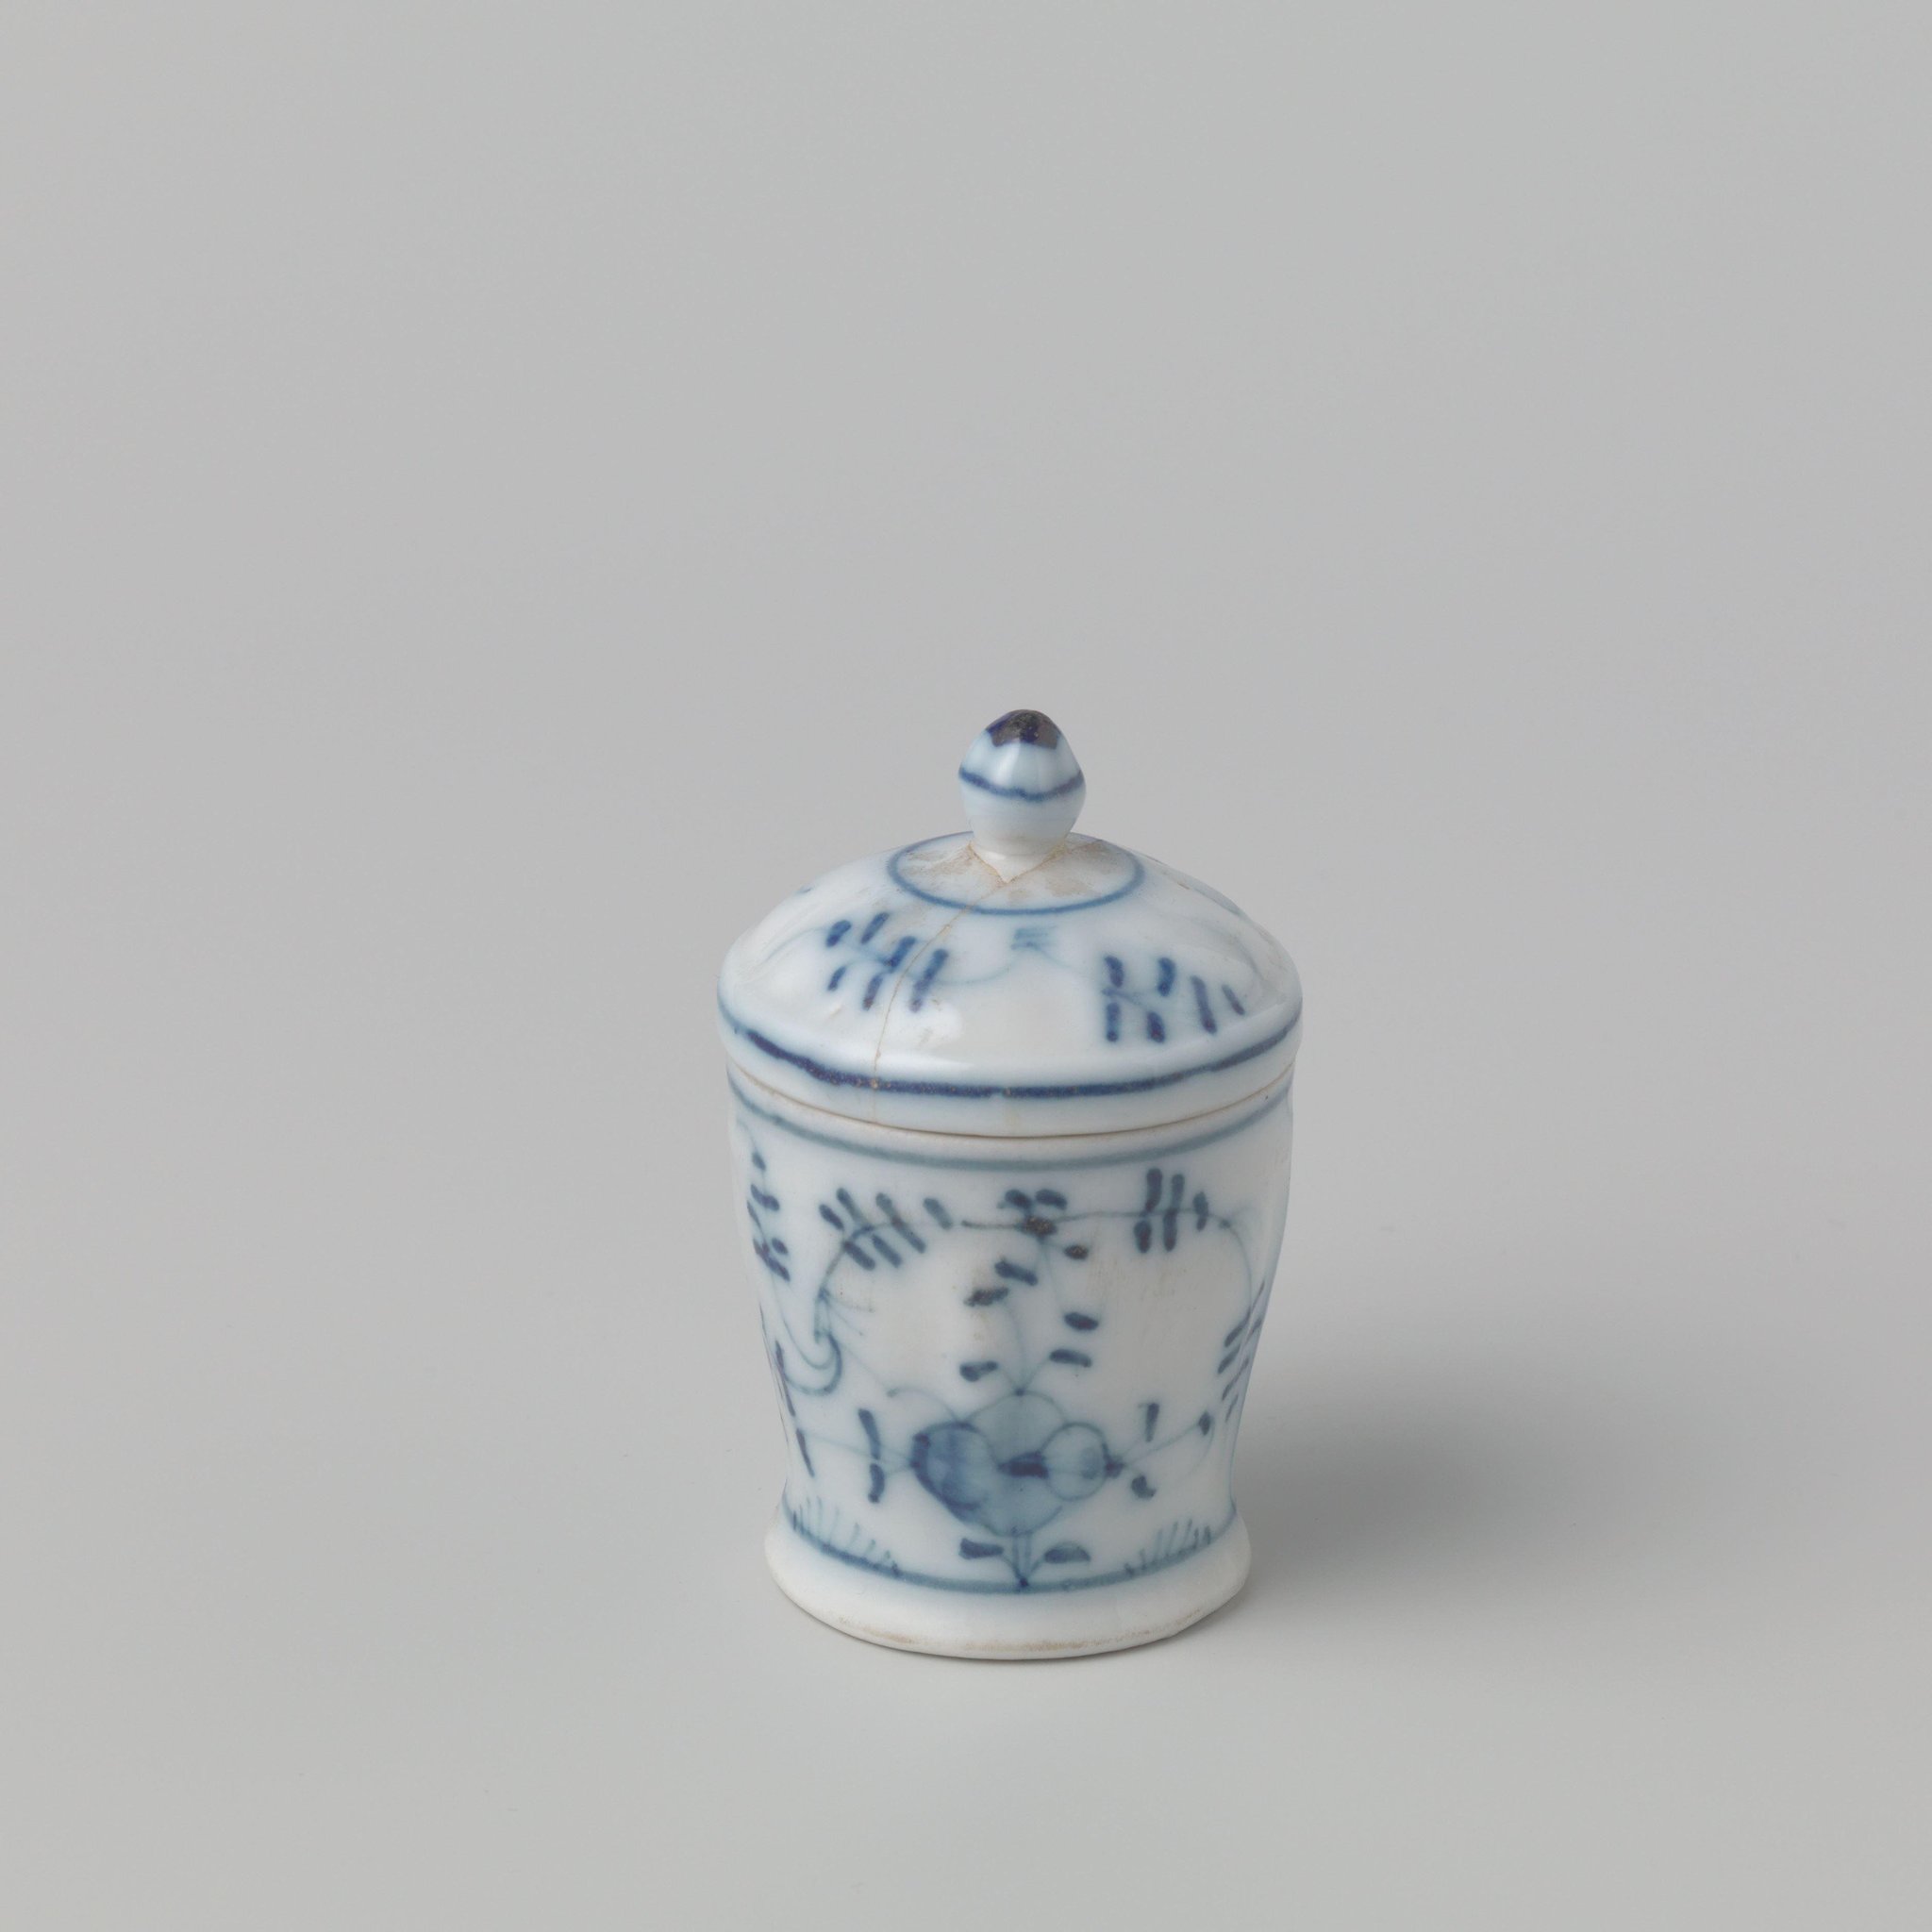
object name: toilet set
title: Poederpotje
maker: Anonymous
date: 1775-1800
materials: ceramic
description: Poederpotje met blauw Saksisch patroon, ongemerkt.